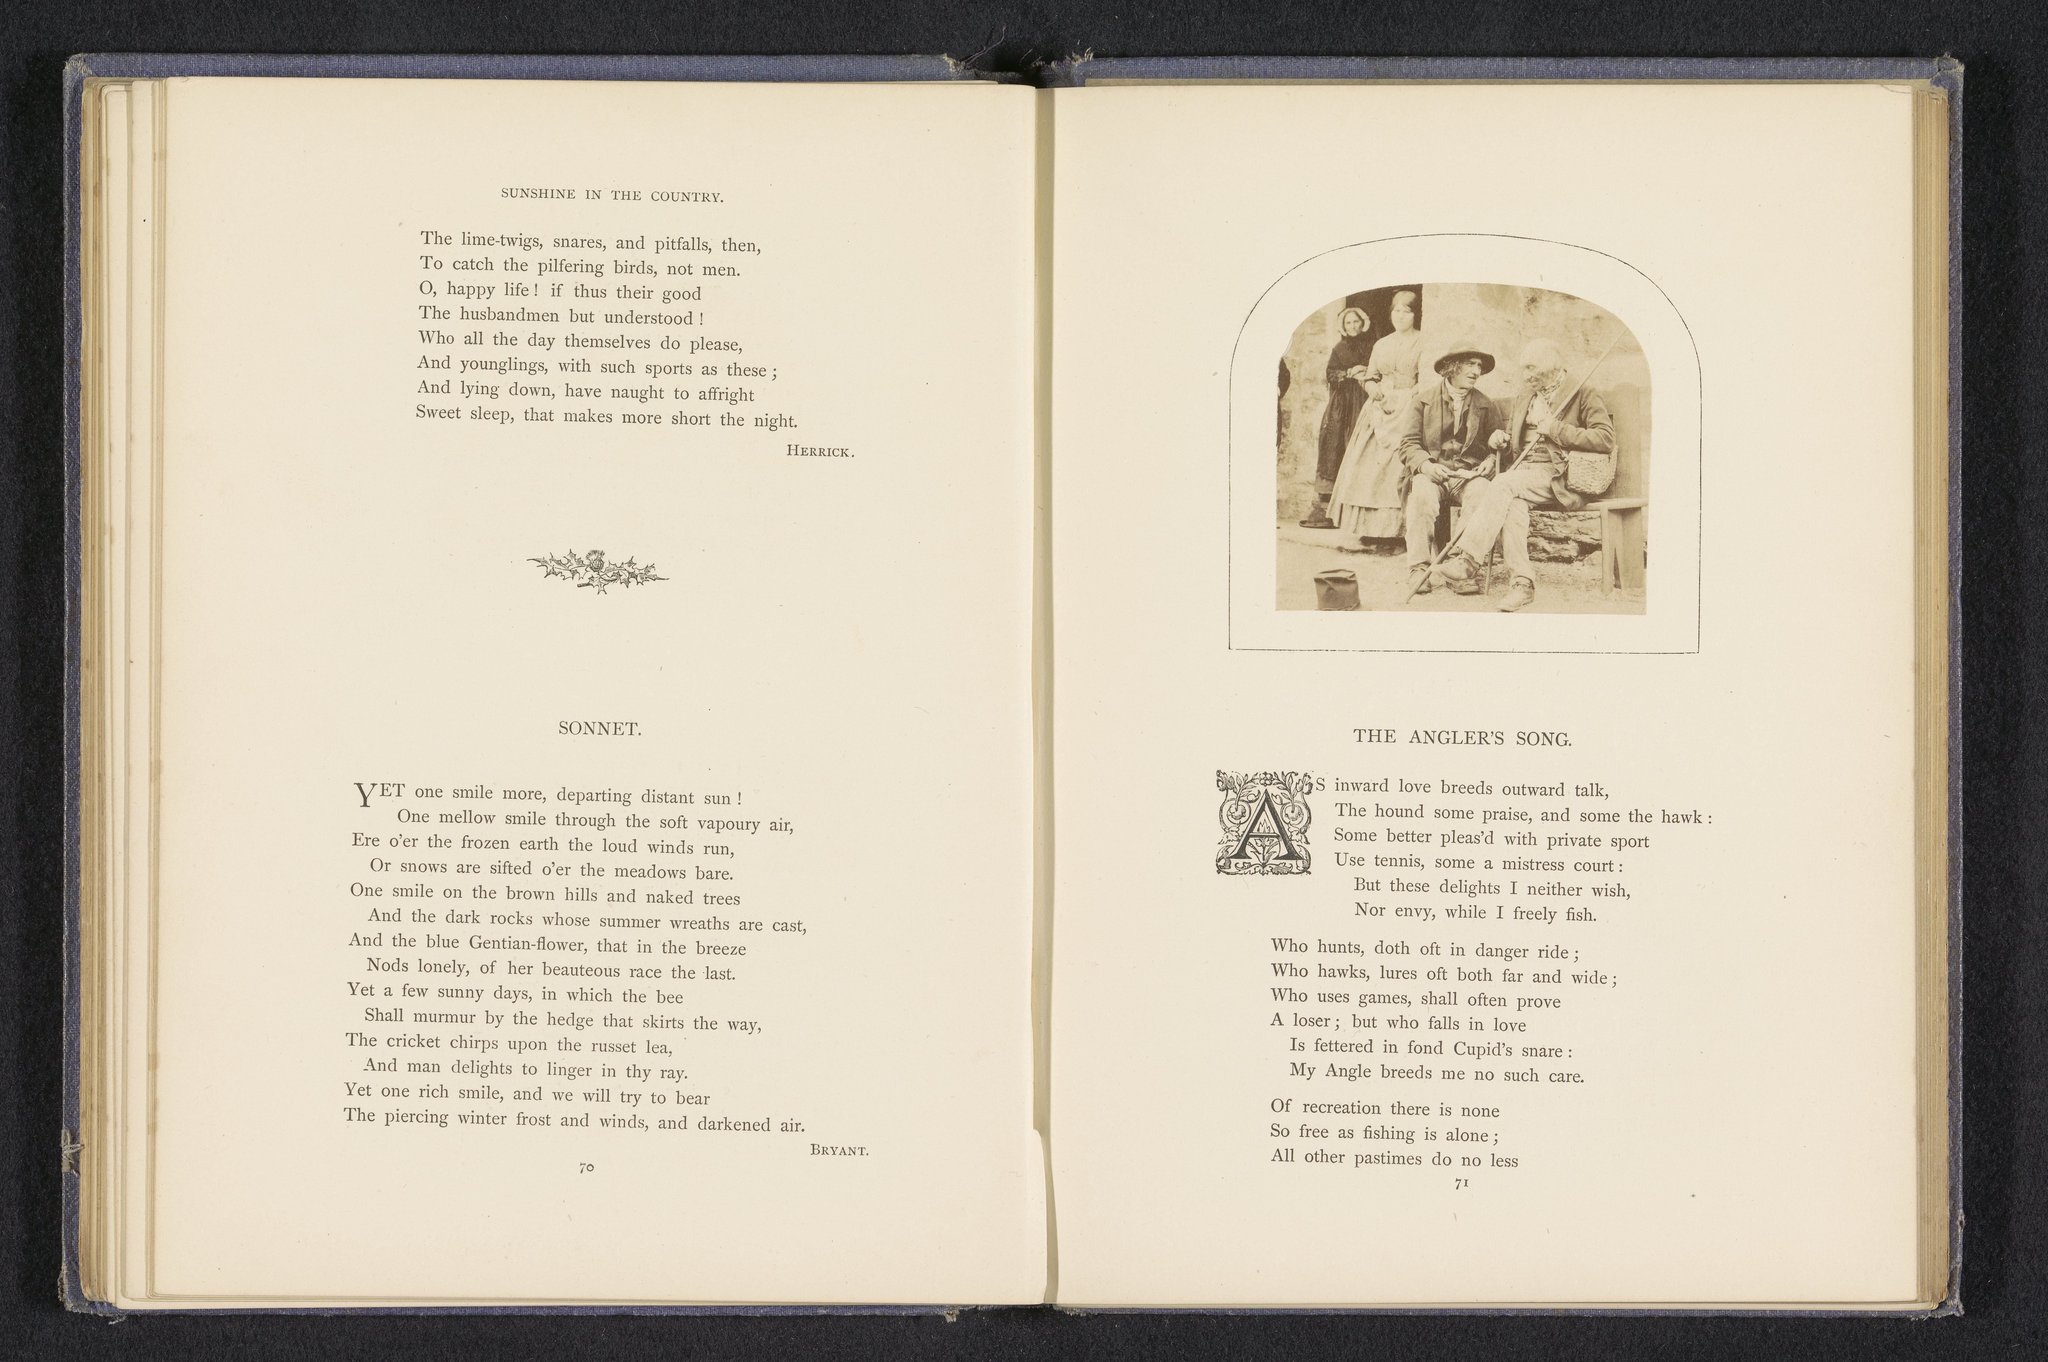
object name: page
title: Twee mannen op een bankje voor een gebouw met vrouwen in de deuropening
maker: william morris grundy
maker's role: fotograaf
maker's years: 1806-1859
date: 1851-1861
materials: photographic support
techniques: albumen print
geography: england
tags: bench, adult man